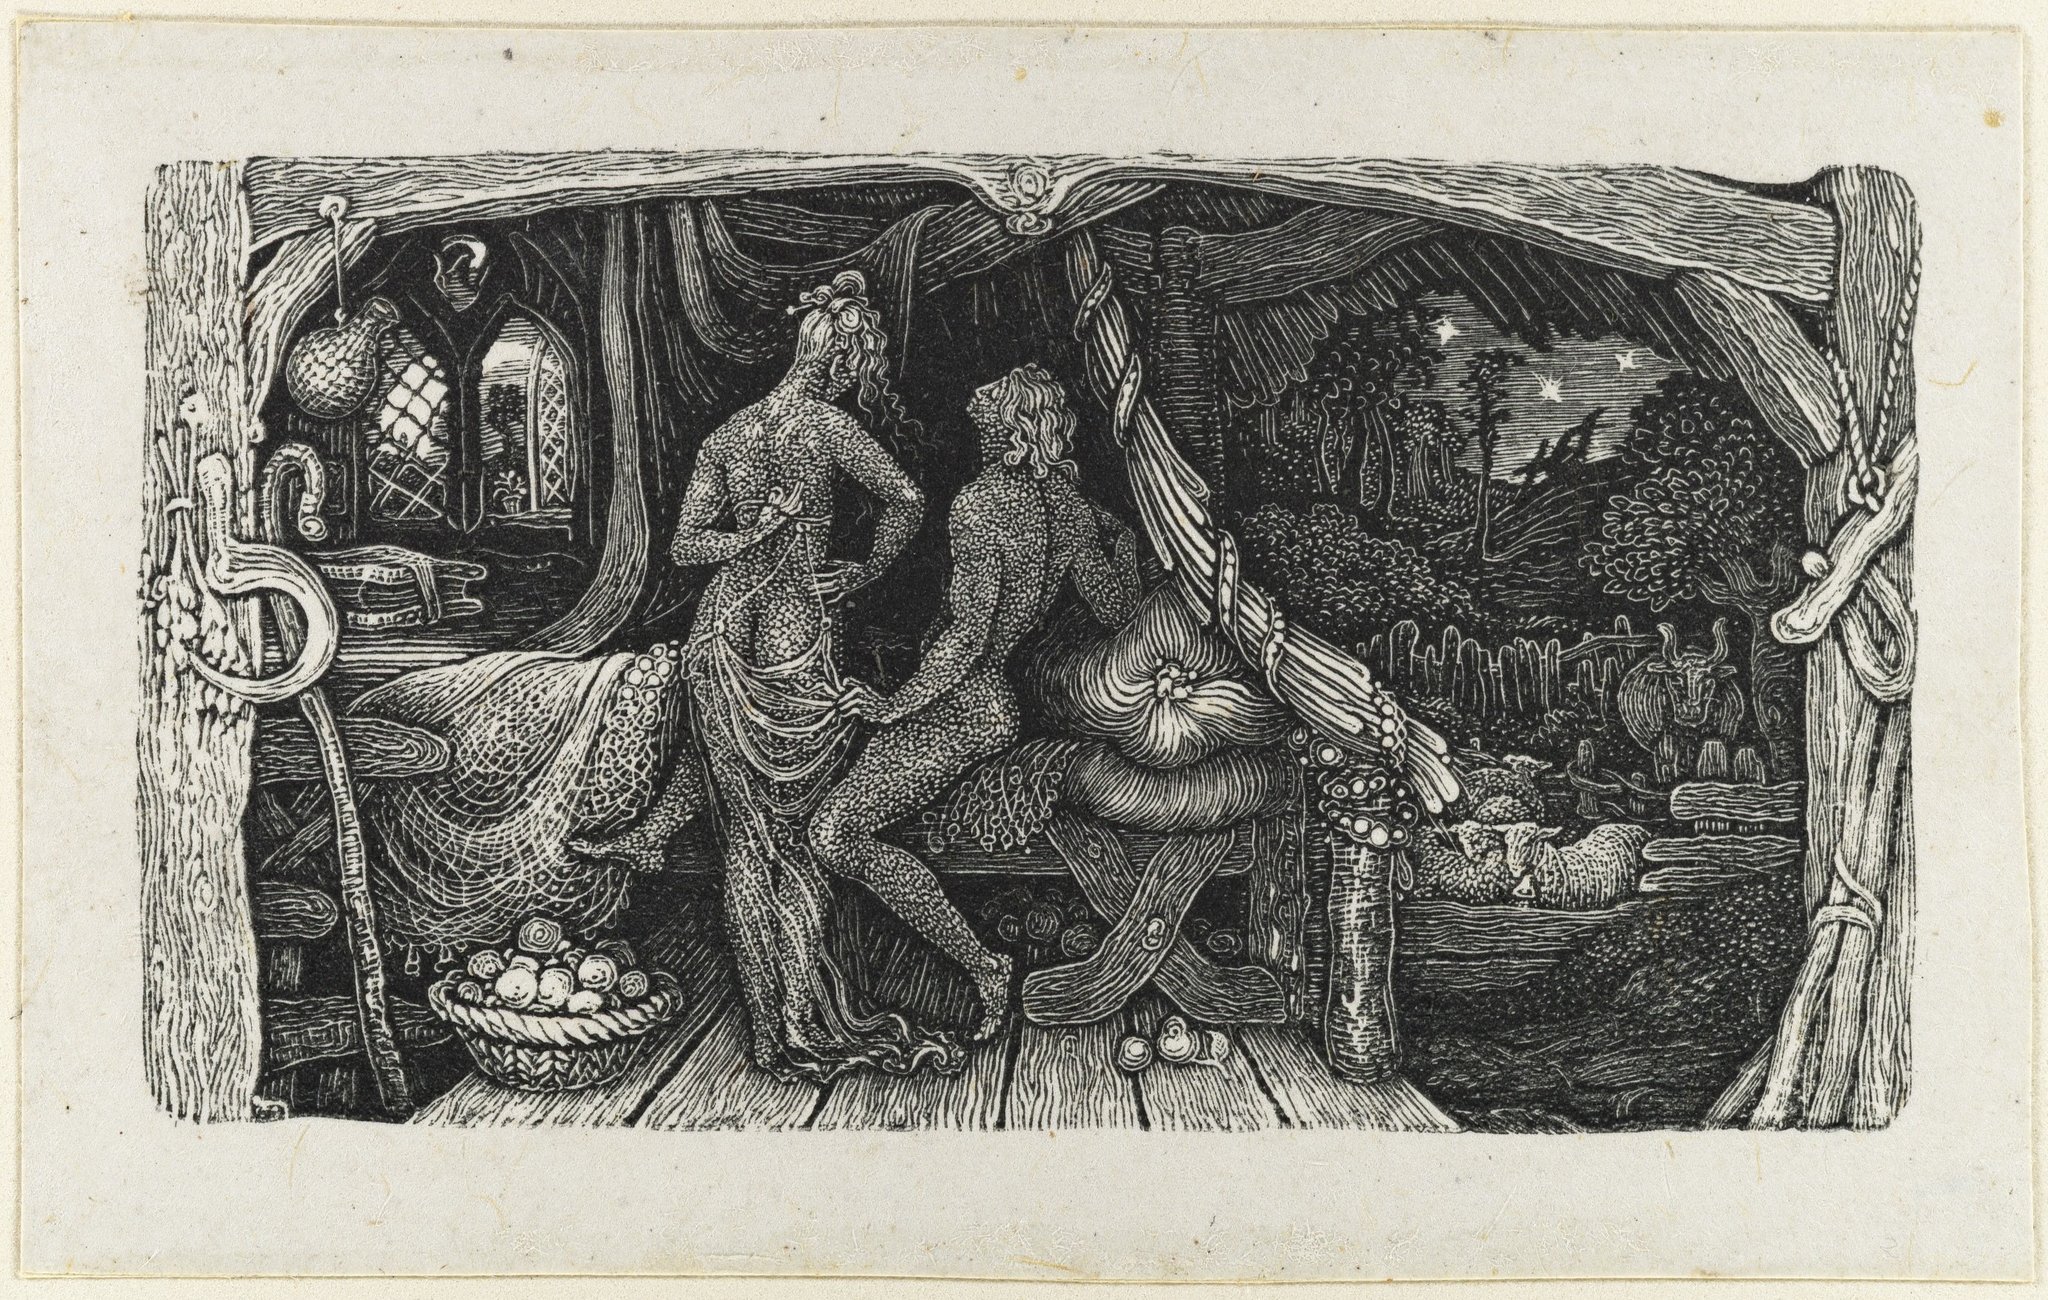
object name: print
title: The Chamber Idyll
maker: edward calvert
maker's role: artist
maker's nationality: british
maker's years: 1799-1883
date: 1831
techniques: engraving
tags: couples,male nudes,lovers,female nudes,beds